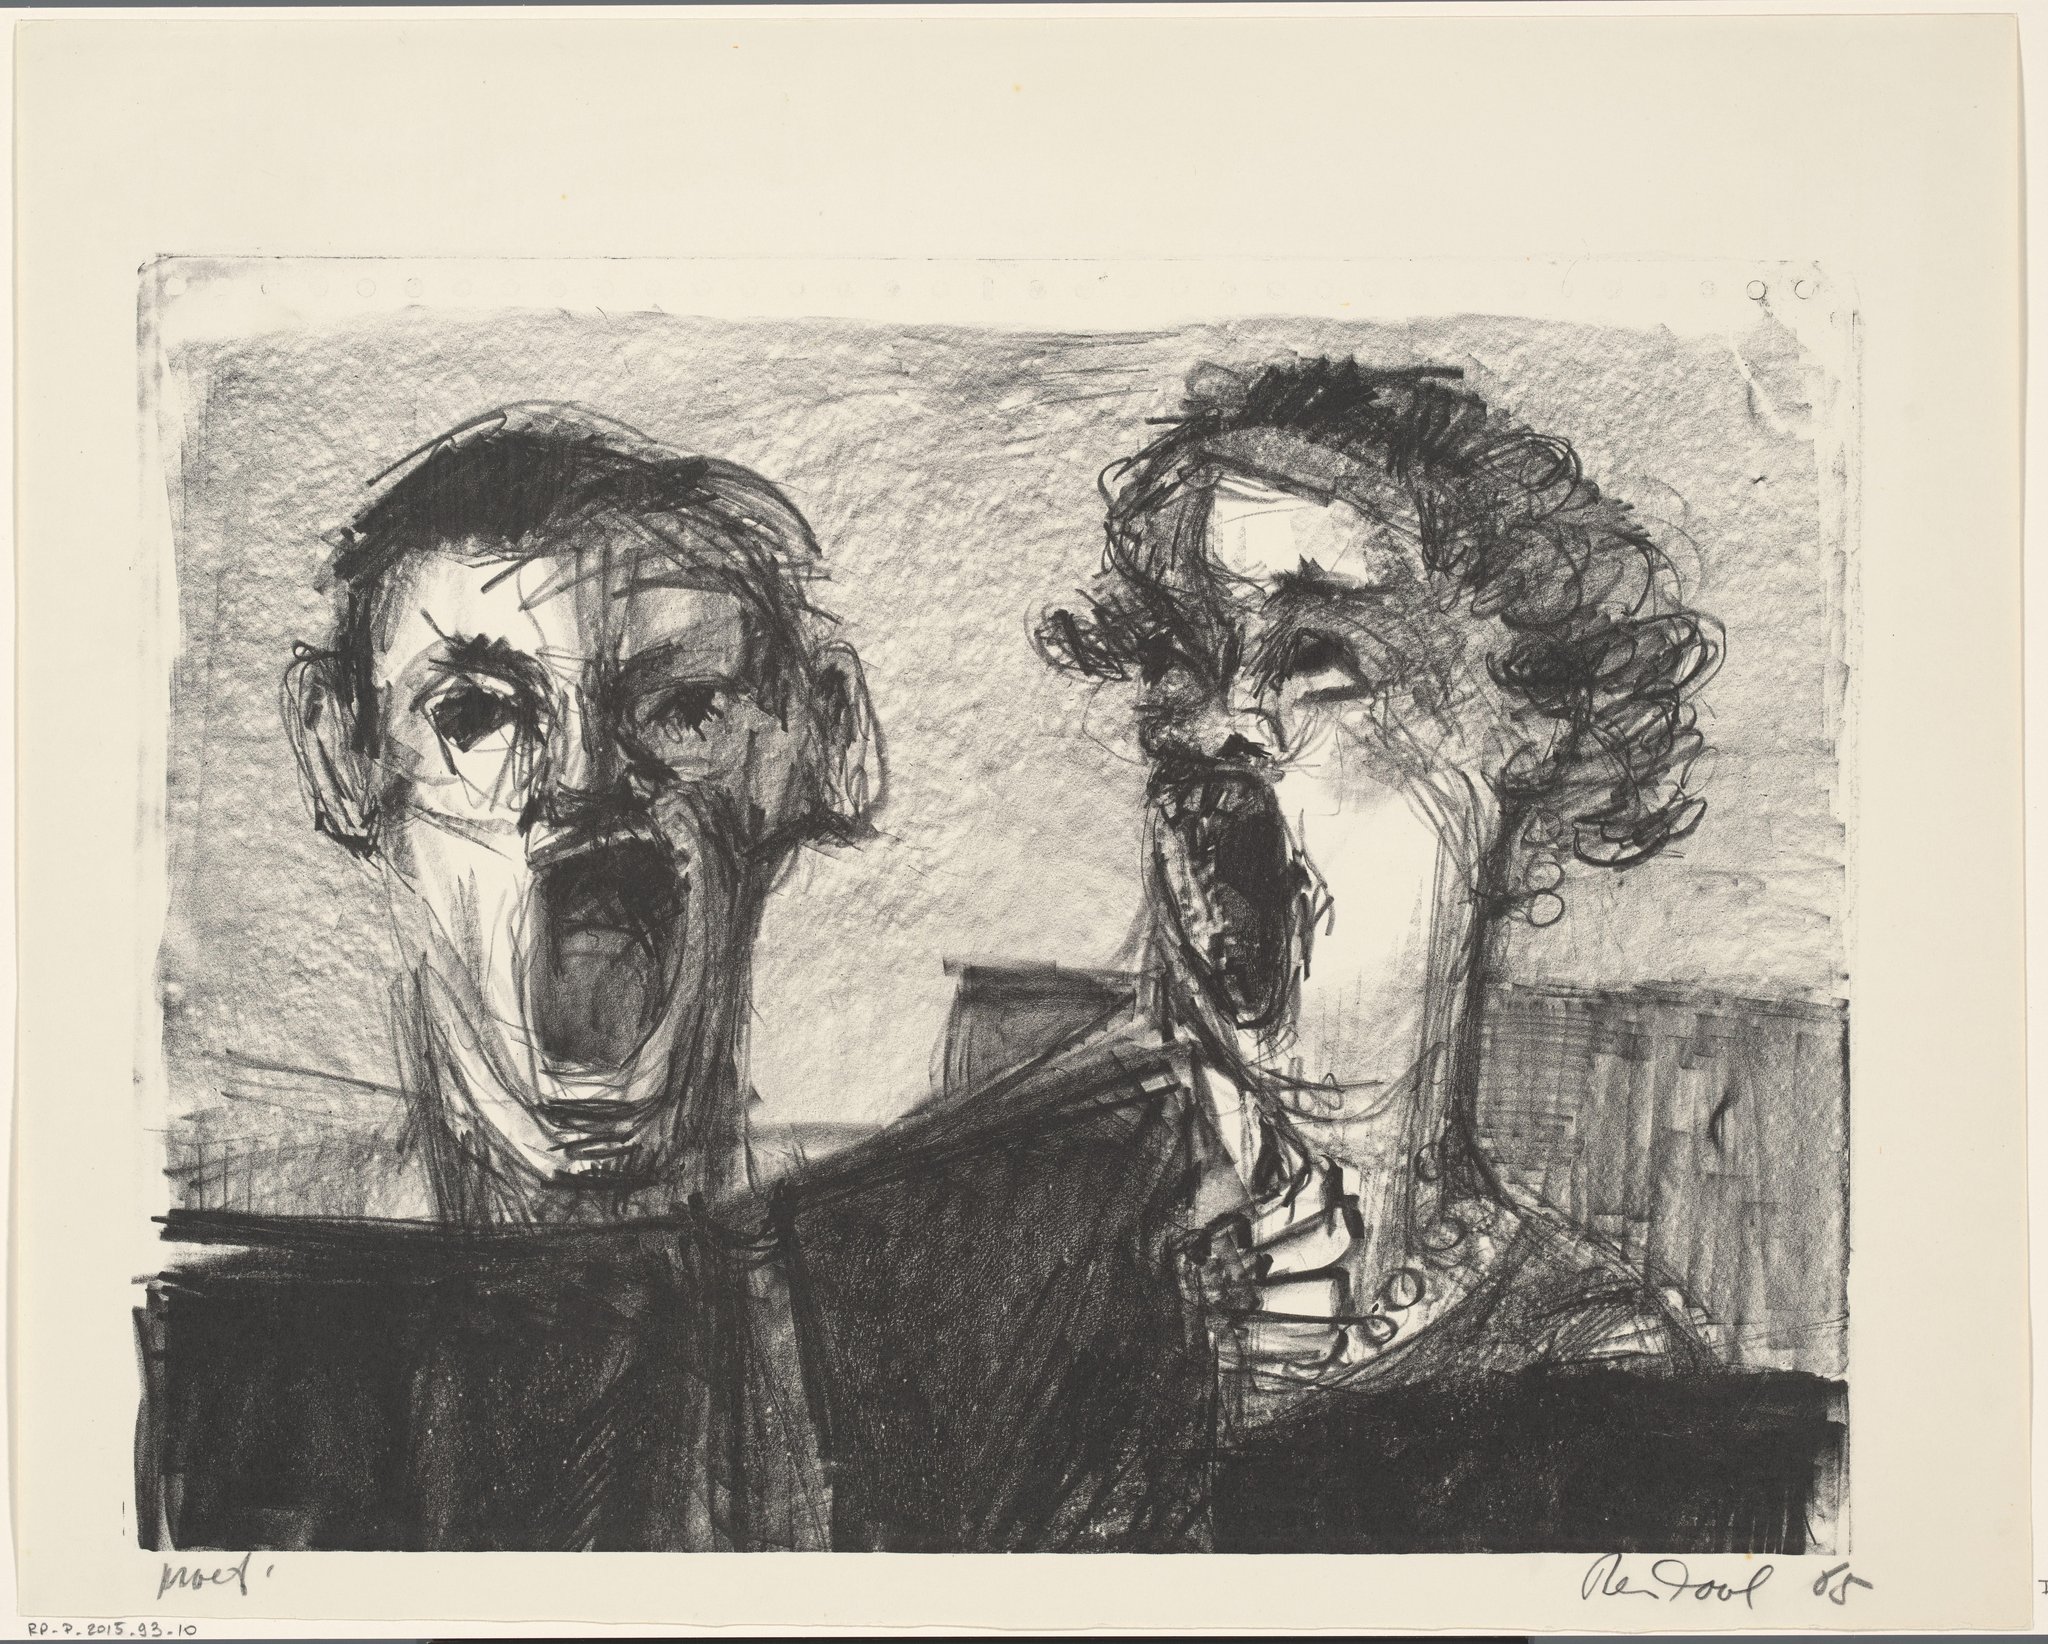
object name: print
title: Zangers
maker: rein dool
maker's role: draughtsman, painter, print maker, sculptor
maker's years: 1933-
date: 1965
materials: paper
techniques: lithograph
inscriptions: signature and date